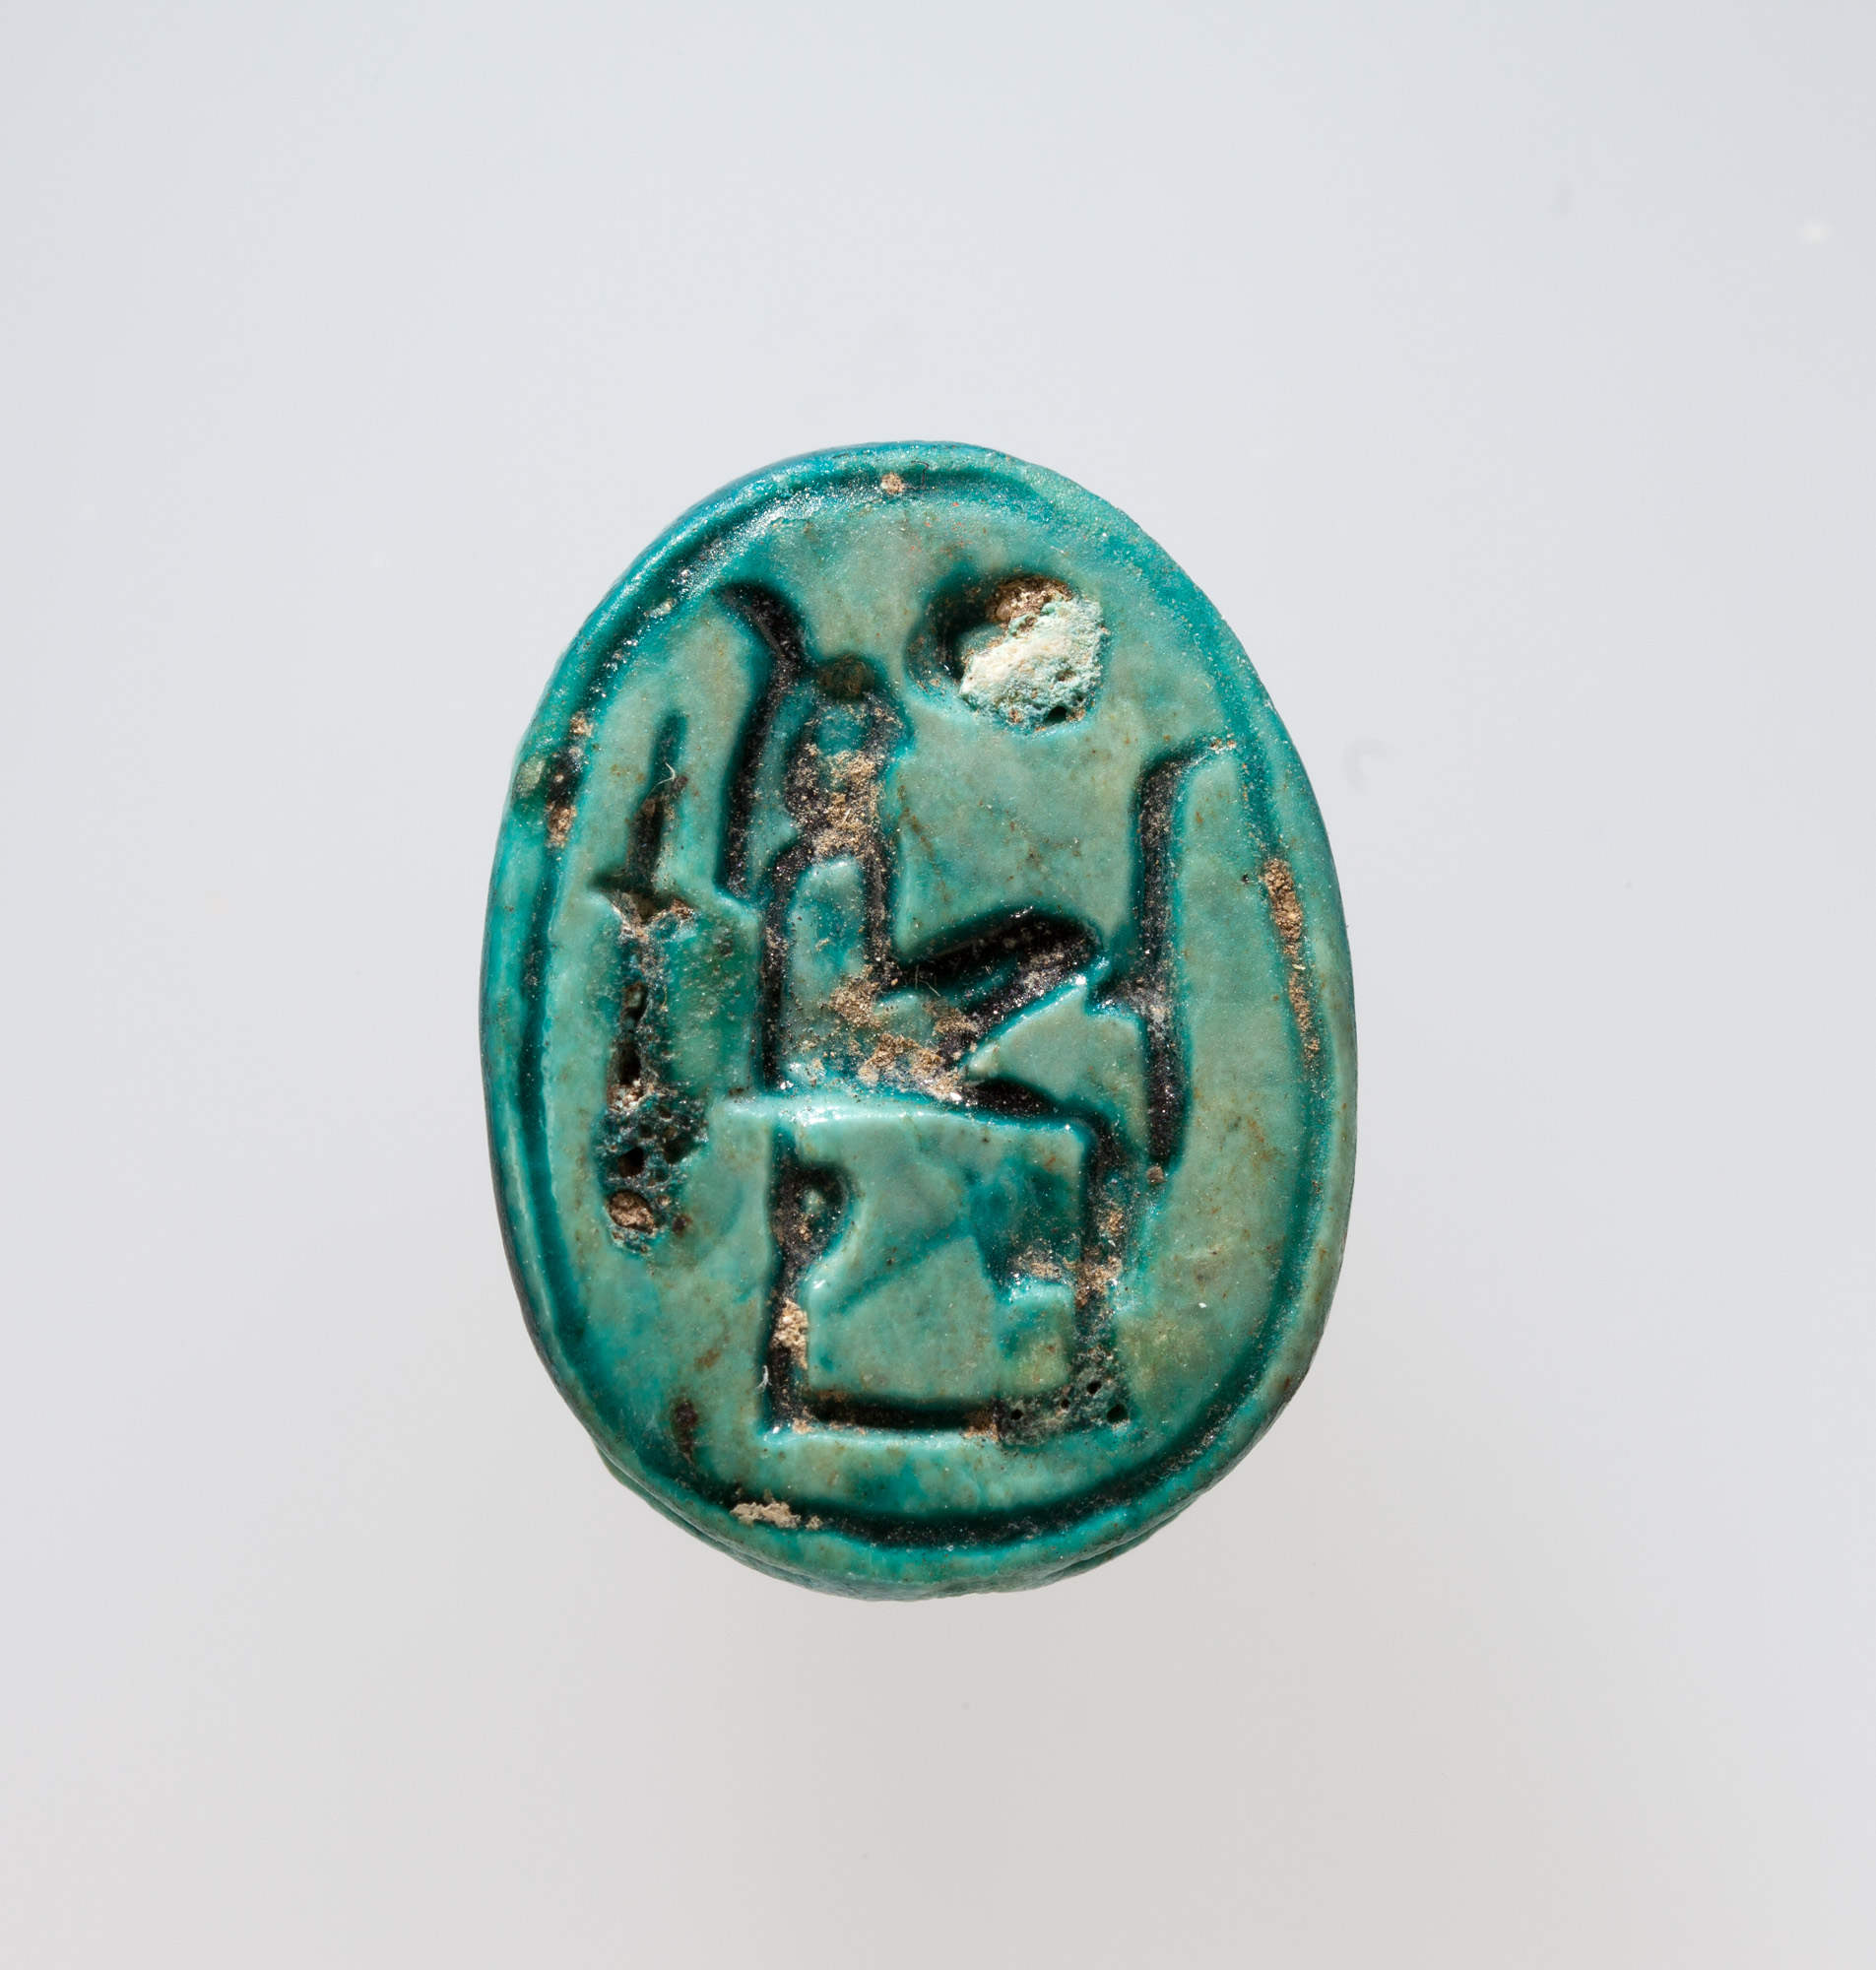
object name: scarab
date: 1479-1458 BCE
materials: faience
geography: egypt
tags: scarabs